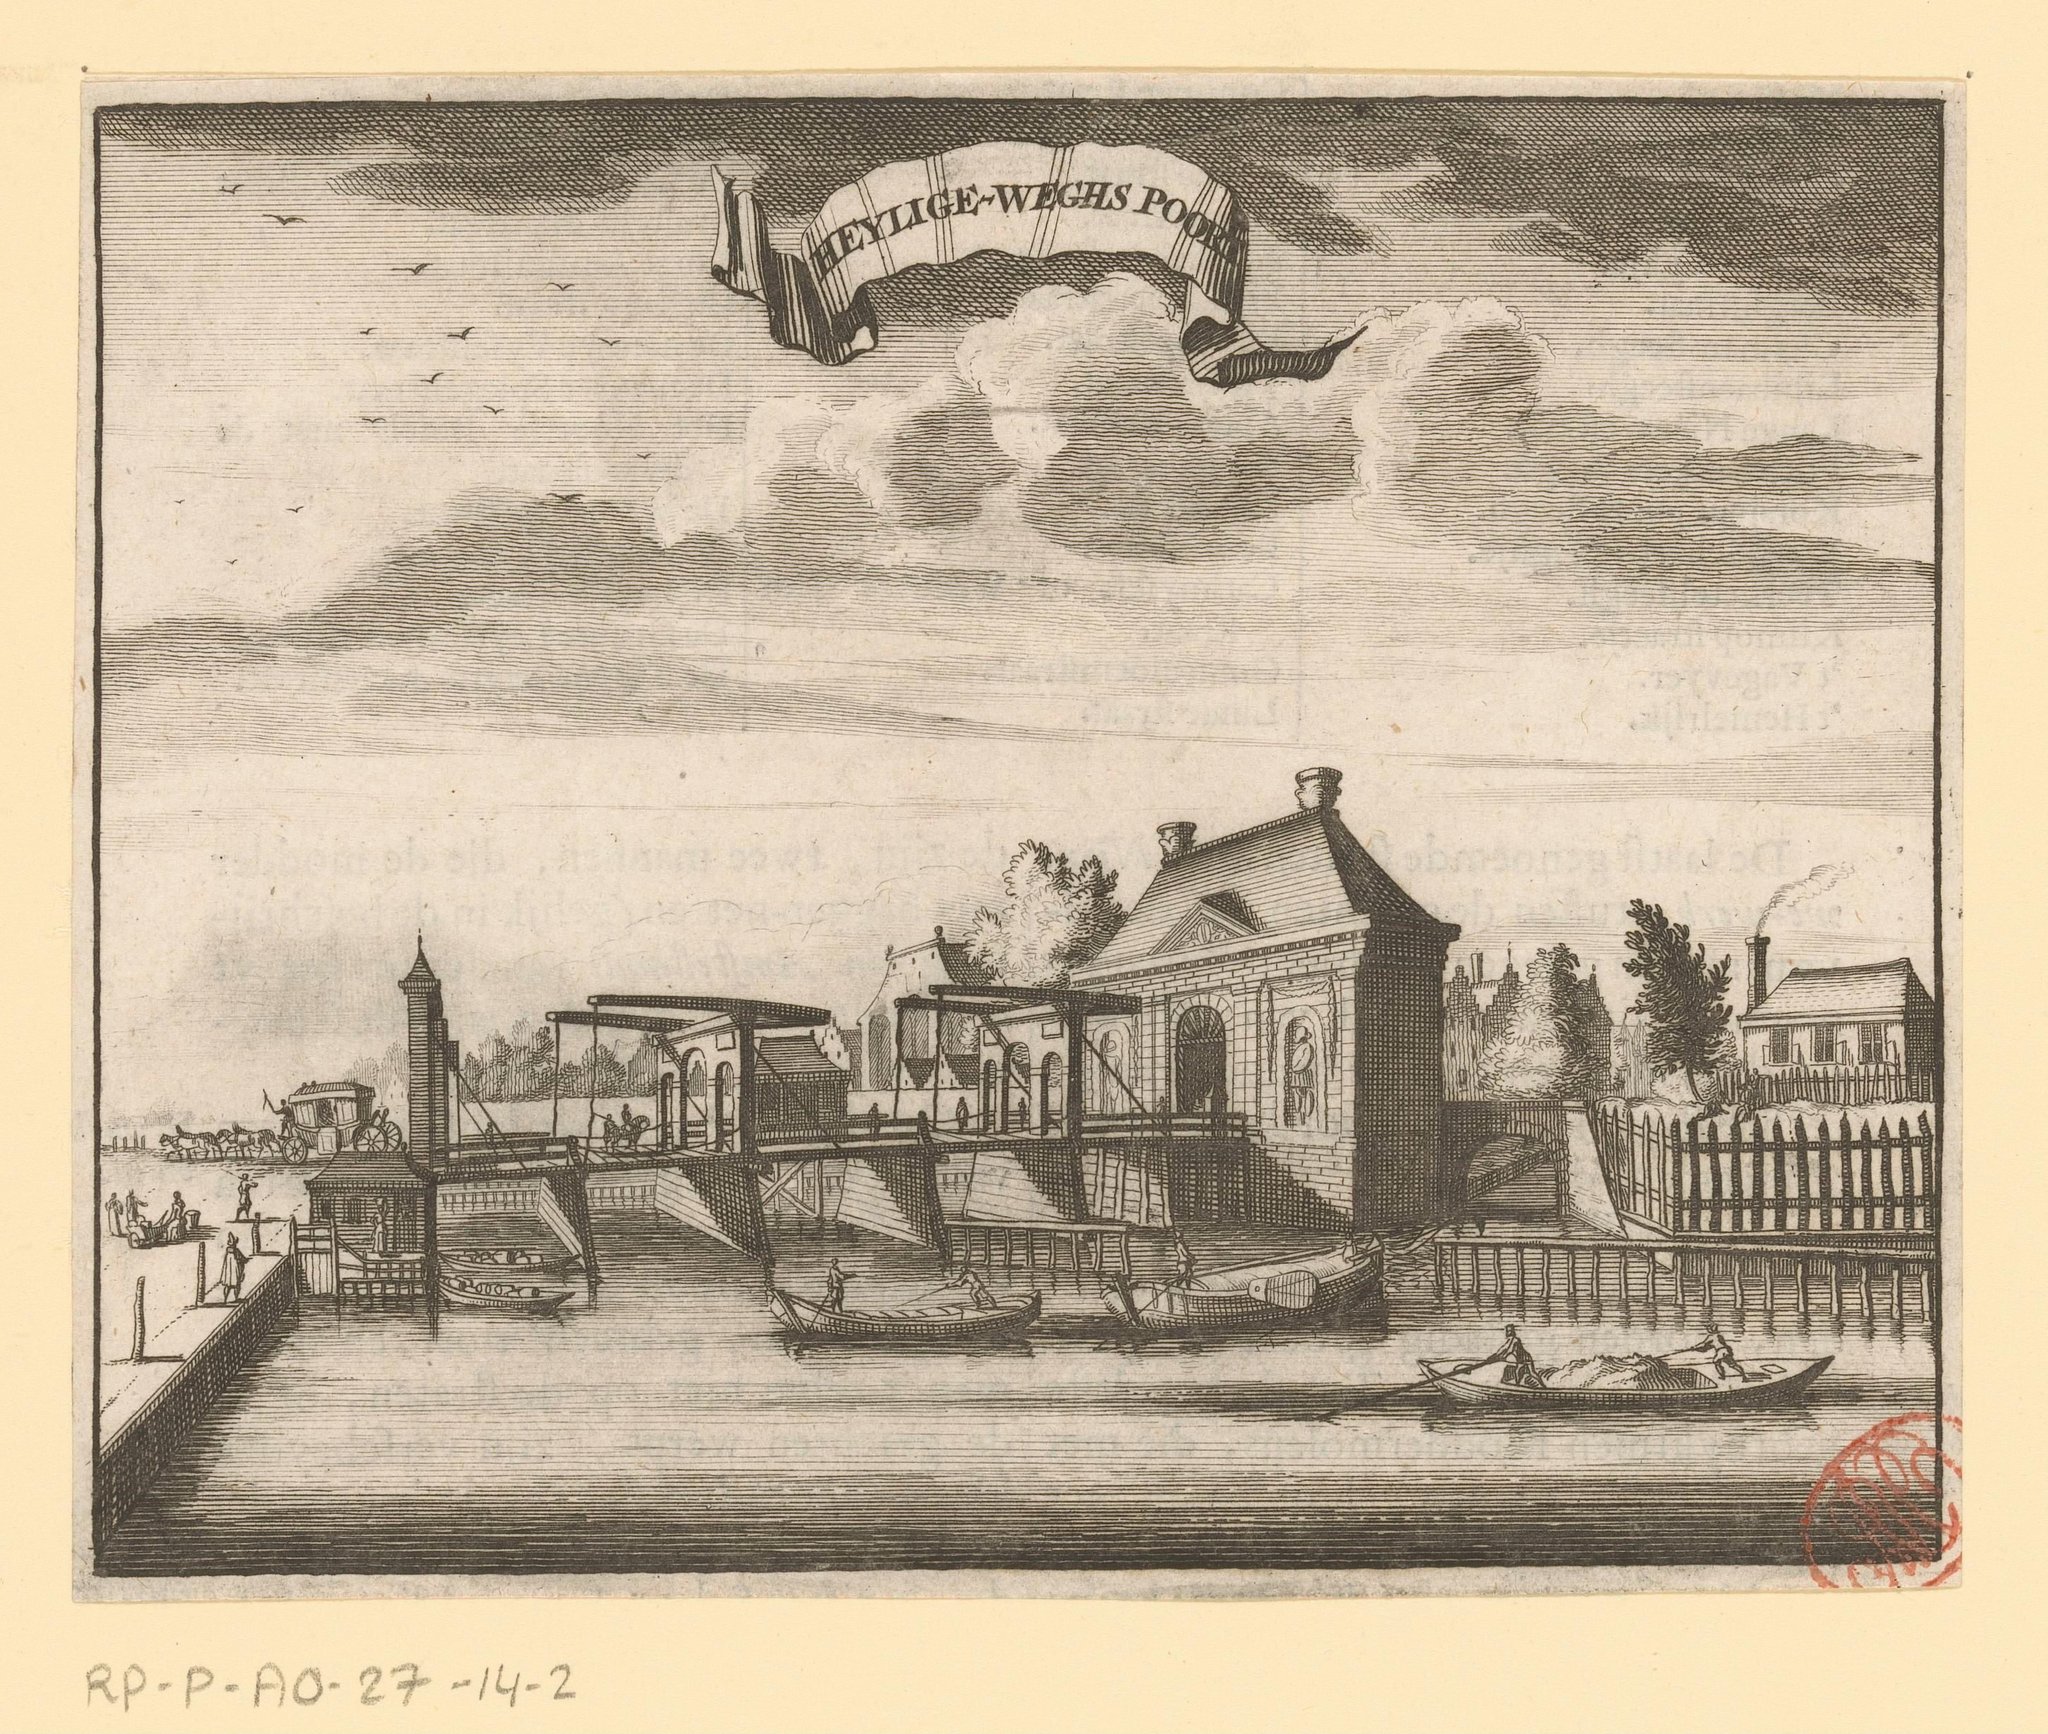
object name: book illustration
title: Gezicht op de Derde Heiligewegspoort te Amsterdam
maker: Anonymous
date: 1693-1694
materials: paper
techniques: engraving, etching, letterpress printing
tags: bridge, city-gate, canal (+ landscape with figures, staffage)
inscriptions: collector's mark: Lugt 195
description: Prent gebruikt in: Commelin, Caspar. Beschryvinge van Amsterdam, desselfs eerste oorspronk uyt den Huyse (…). 2 delen. Amsterdam: Abraham Wolfgang, Gillis Janssonius van Waesberge, Johannes Janssonius van Waesberge II, weduwe Dirk Boom I, Hendrick Boom en Rembertus Goethals, 1693. Of in: Commelin, Caspar. Beschryvinge van Amsterdam, zynde een naukeurige verhandelinge van desselfs eerste oorspronk uyt (…). 2 delen. Amsterdam: weduwe Aart Dircksz Oossaan, 1694. Latere staat ook gebruikt in: Commelin, Caspar. Beschryvinge van Amsterdam, zynde een naukeurige verhandelinge van desselfs eerste oorspronk uyt (…). 2 delen. 2e druk. Amsterdam: Andries van Damme, Johannes Ratelband, weduwe A. van Aaltwyk en Hermanus Uytwerf, 1726.